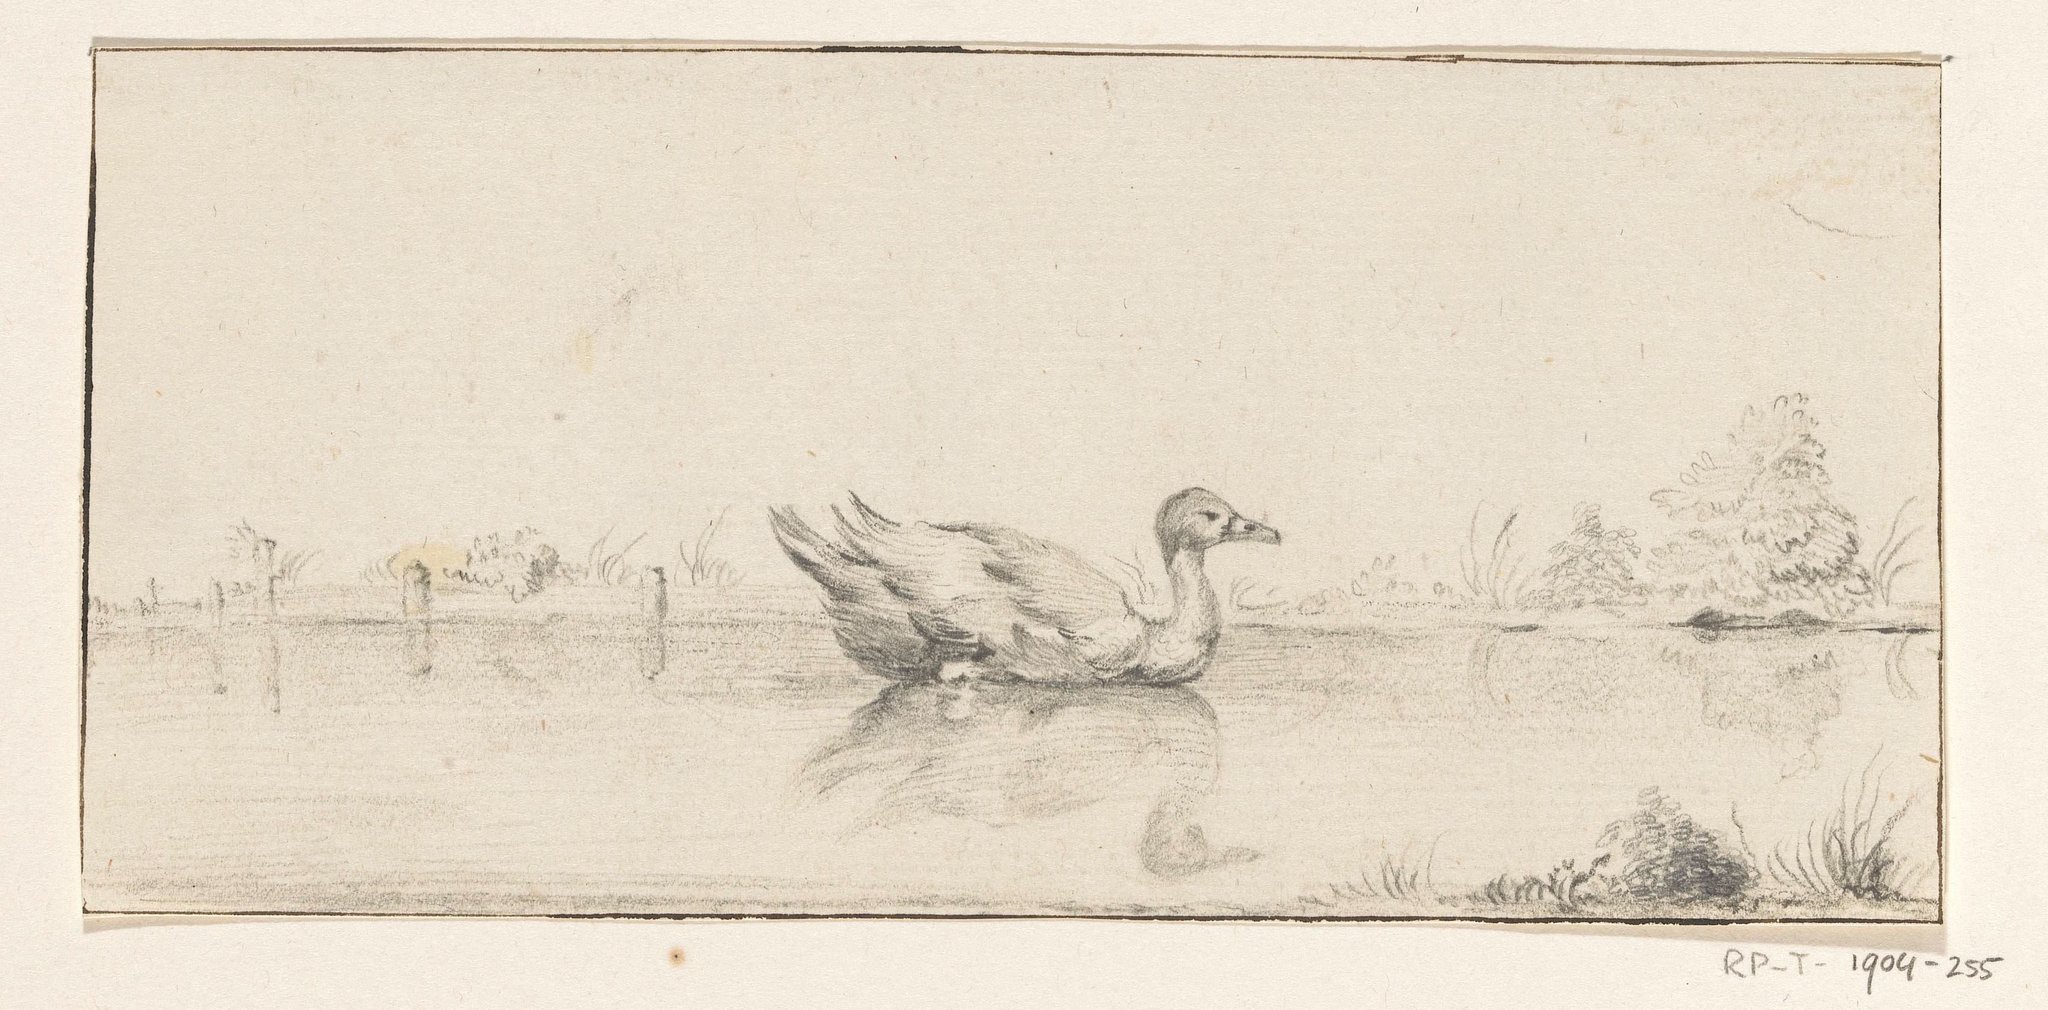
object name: drawing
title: Eend in het water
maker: jean bernard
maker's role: draughtsman, print maker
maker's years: 1765-1833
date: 1775-1833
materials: chalk, paper, pencil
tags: ducks (domestic waterbirds), water-birds: duck